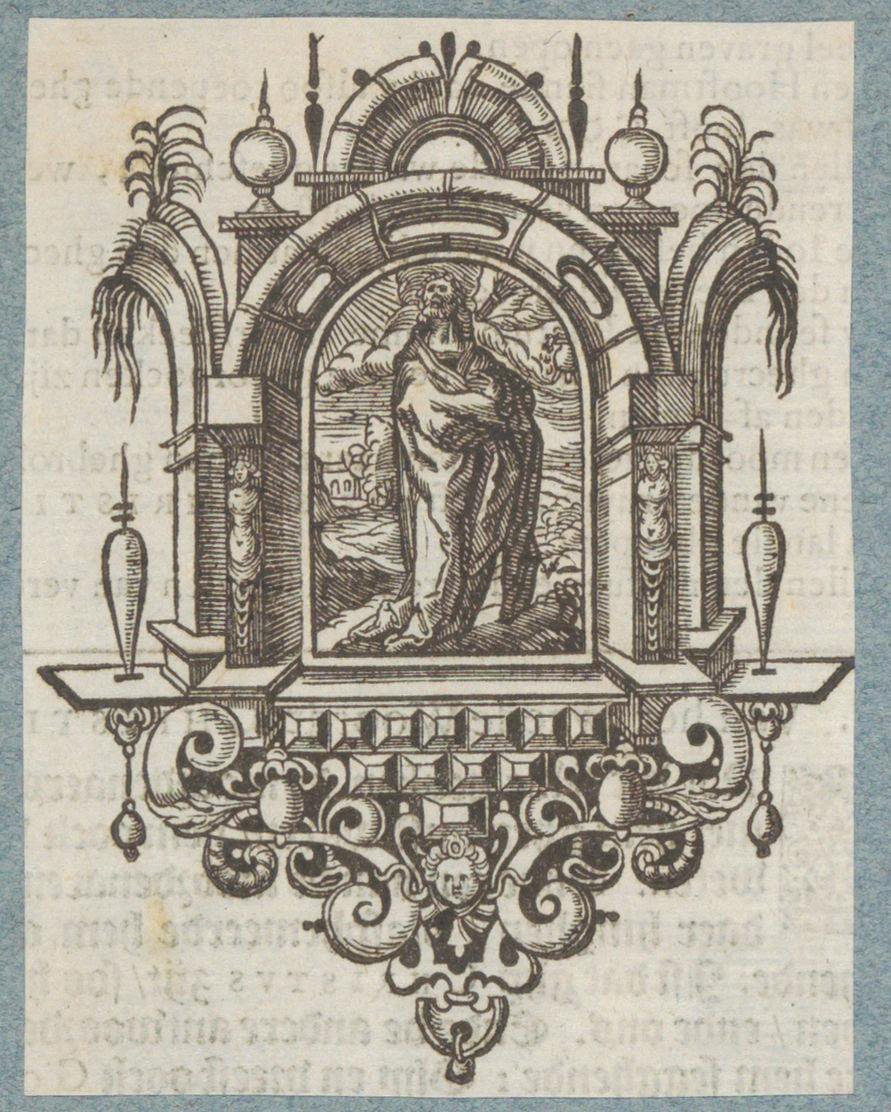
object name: album leaf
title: Profeet Jeremia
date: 1629-1646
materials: paper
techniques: letterpress printing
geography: haarlem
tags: jeremiah (not in biblical context); possible attributes: book or scroll, 'the seething pot'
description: De prent is afkomstig uit een van de uitgaven van P.J. Paets uit Amsterdam. De prent wordt mogelijk al gebruikt in: Der Zielen Lust-hof. Leuven, I.Jacbosz voor P.J. Paets [= Amsterdam, P.J. Paets], 1629. Ze komt in ieder geval voor in: Het Nieuwe Testament ons Salichmaeckers Jesu Christi. Amsterdam, P.J. Paets, 1646.